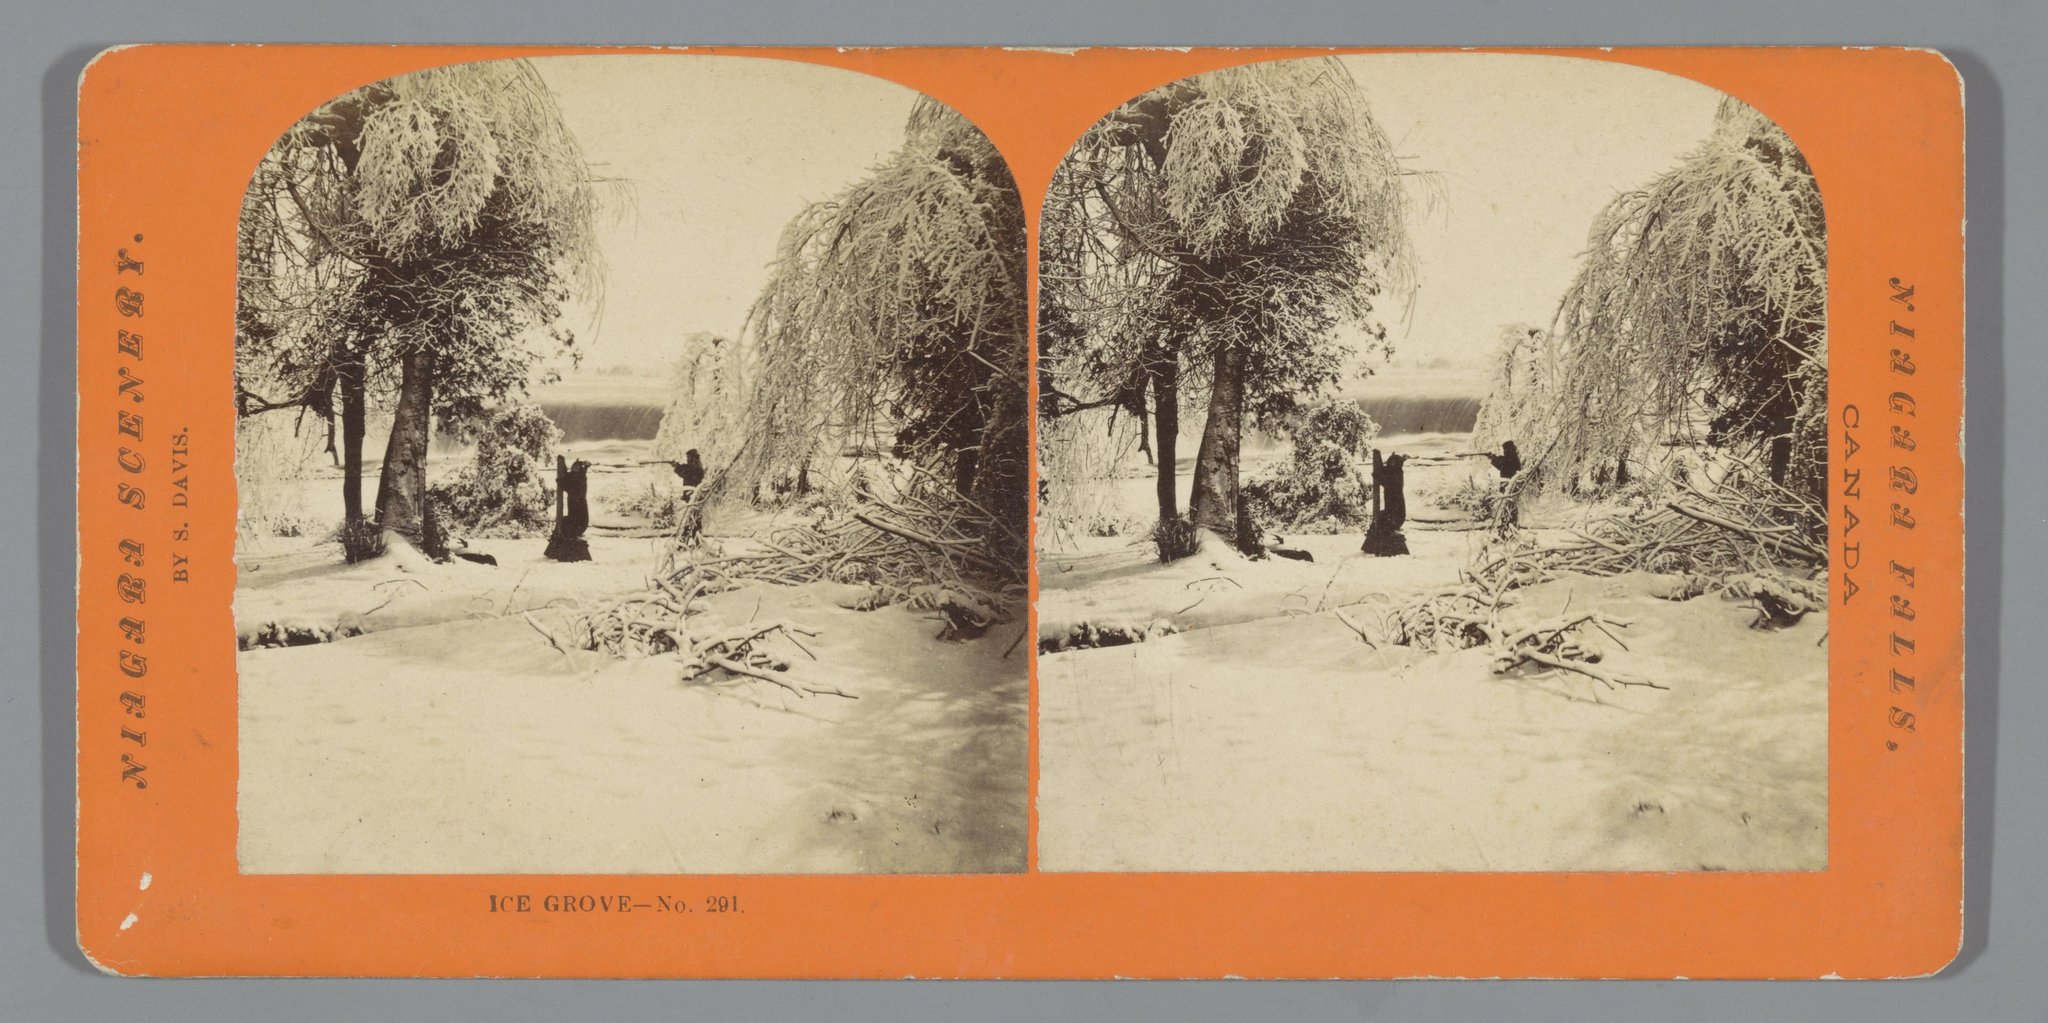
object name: stereograph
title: Man schiet op een vastgebonden beer in een besneeuwd landschap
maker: saul davis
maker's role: fotograaf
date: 1868-1890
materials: cardboard, paper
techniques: albumen print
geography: niagara falls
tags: hunter, beasts of prey, predatory animals: bear, snow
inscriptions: number: ‘No. 291’